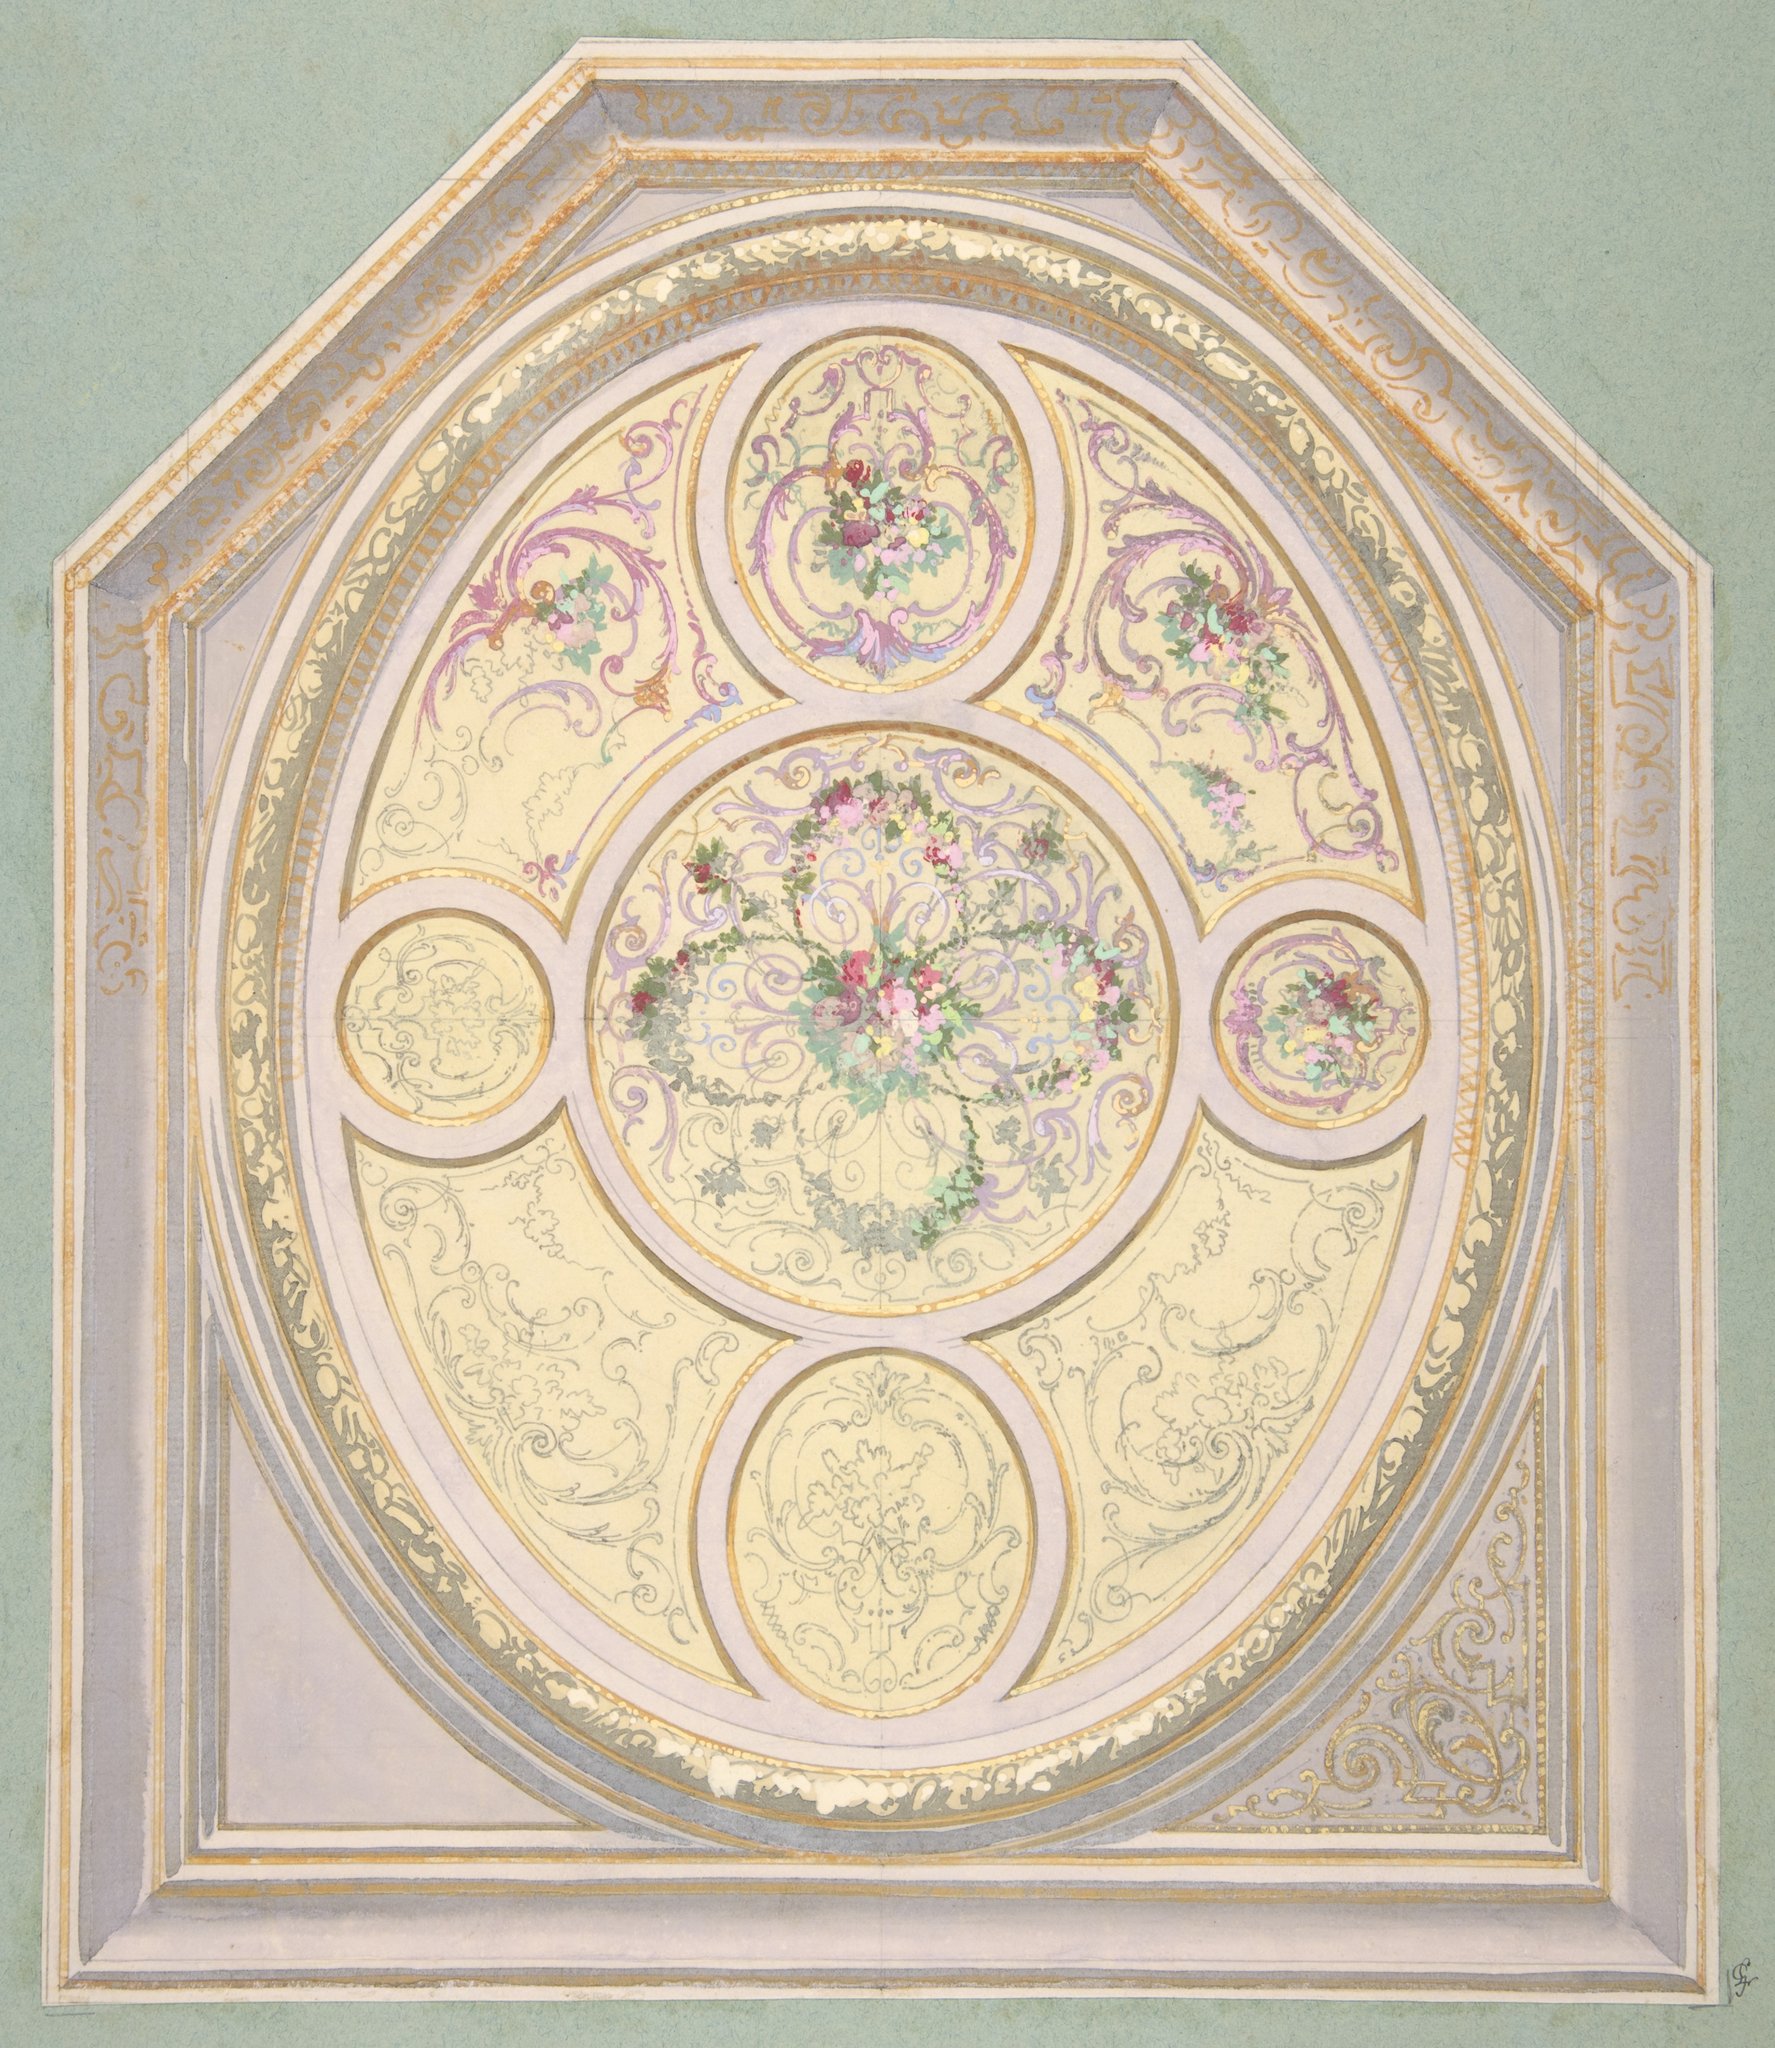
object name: drawing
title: Design for a ceiling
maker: jules-edmond-charles lachaise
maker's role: artist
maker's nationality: french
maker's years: 1897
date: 1851-1900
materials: gouache, graphite, watercolor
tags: ornament,ceilings